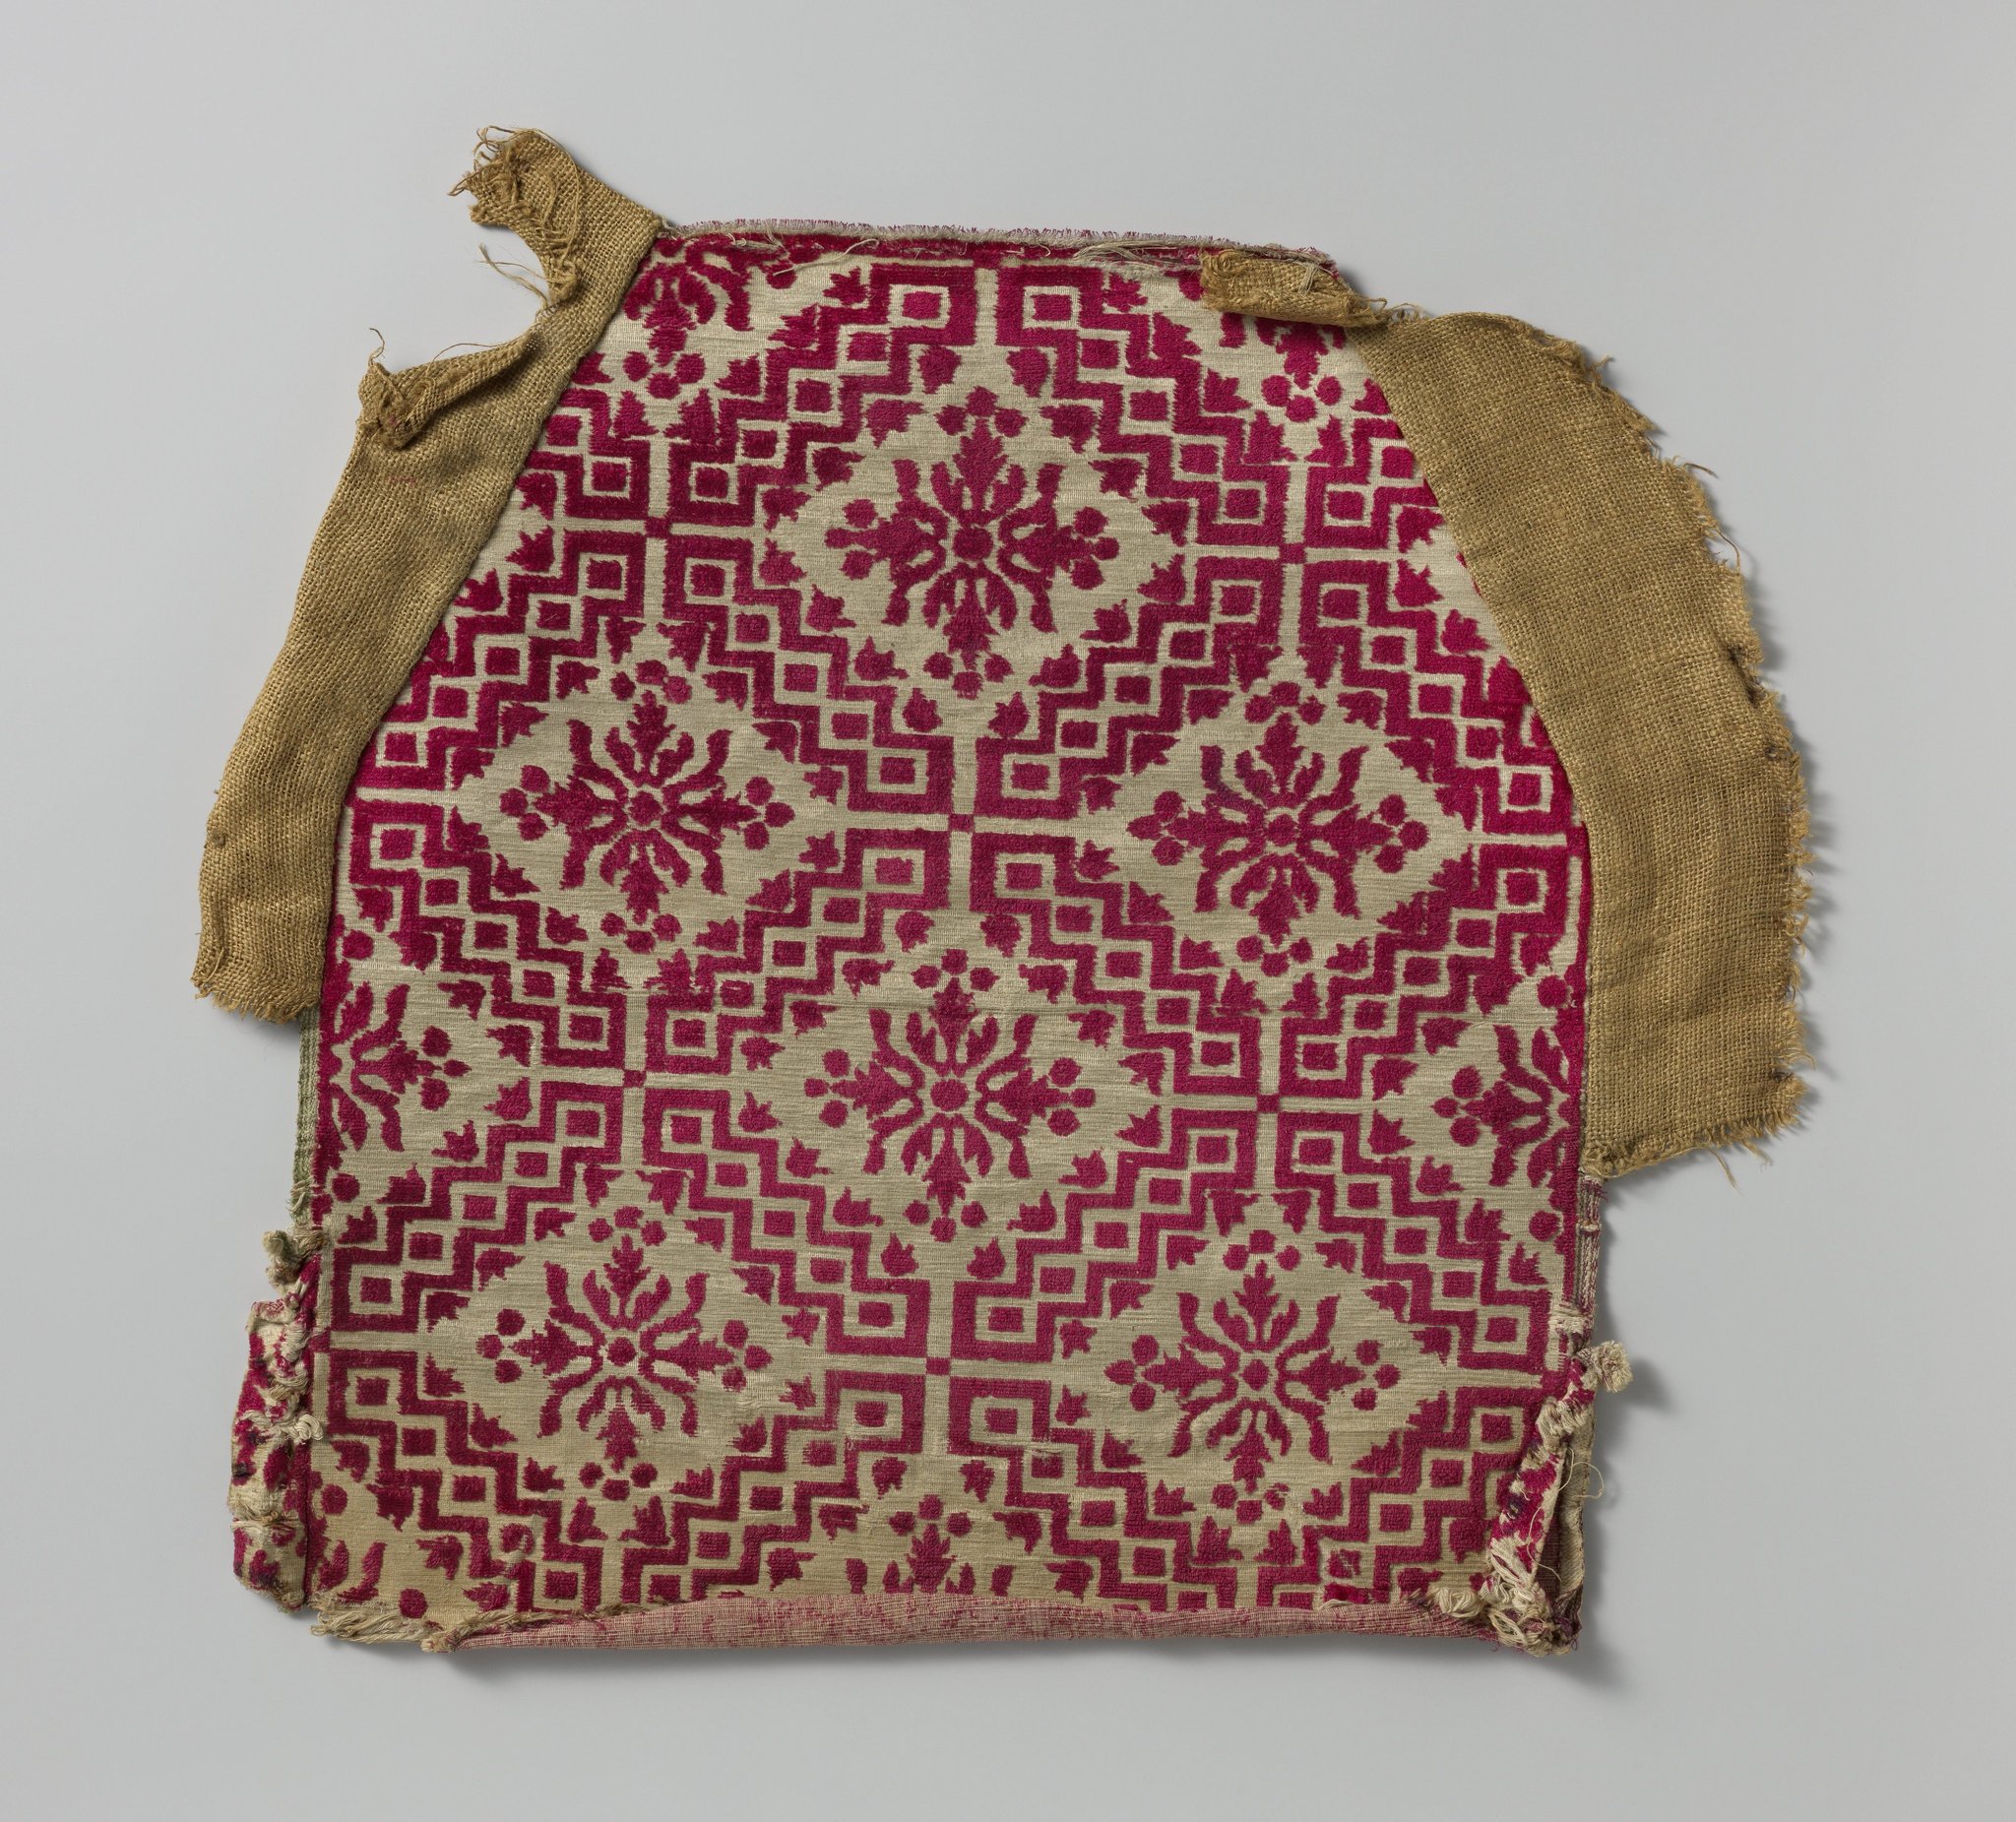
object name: stressed skin structure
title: Fragment stoelbekleding in rood en wit fluweel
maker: Anonymous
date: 1600-1699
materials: cotton, silk, velvet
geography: western europe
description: Rugstuk van een stoelbekleding van geciseleerd zijden fluweel.